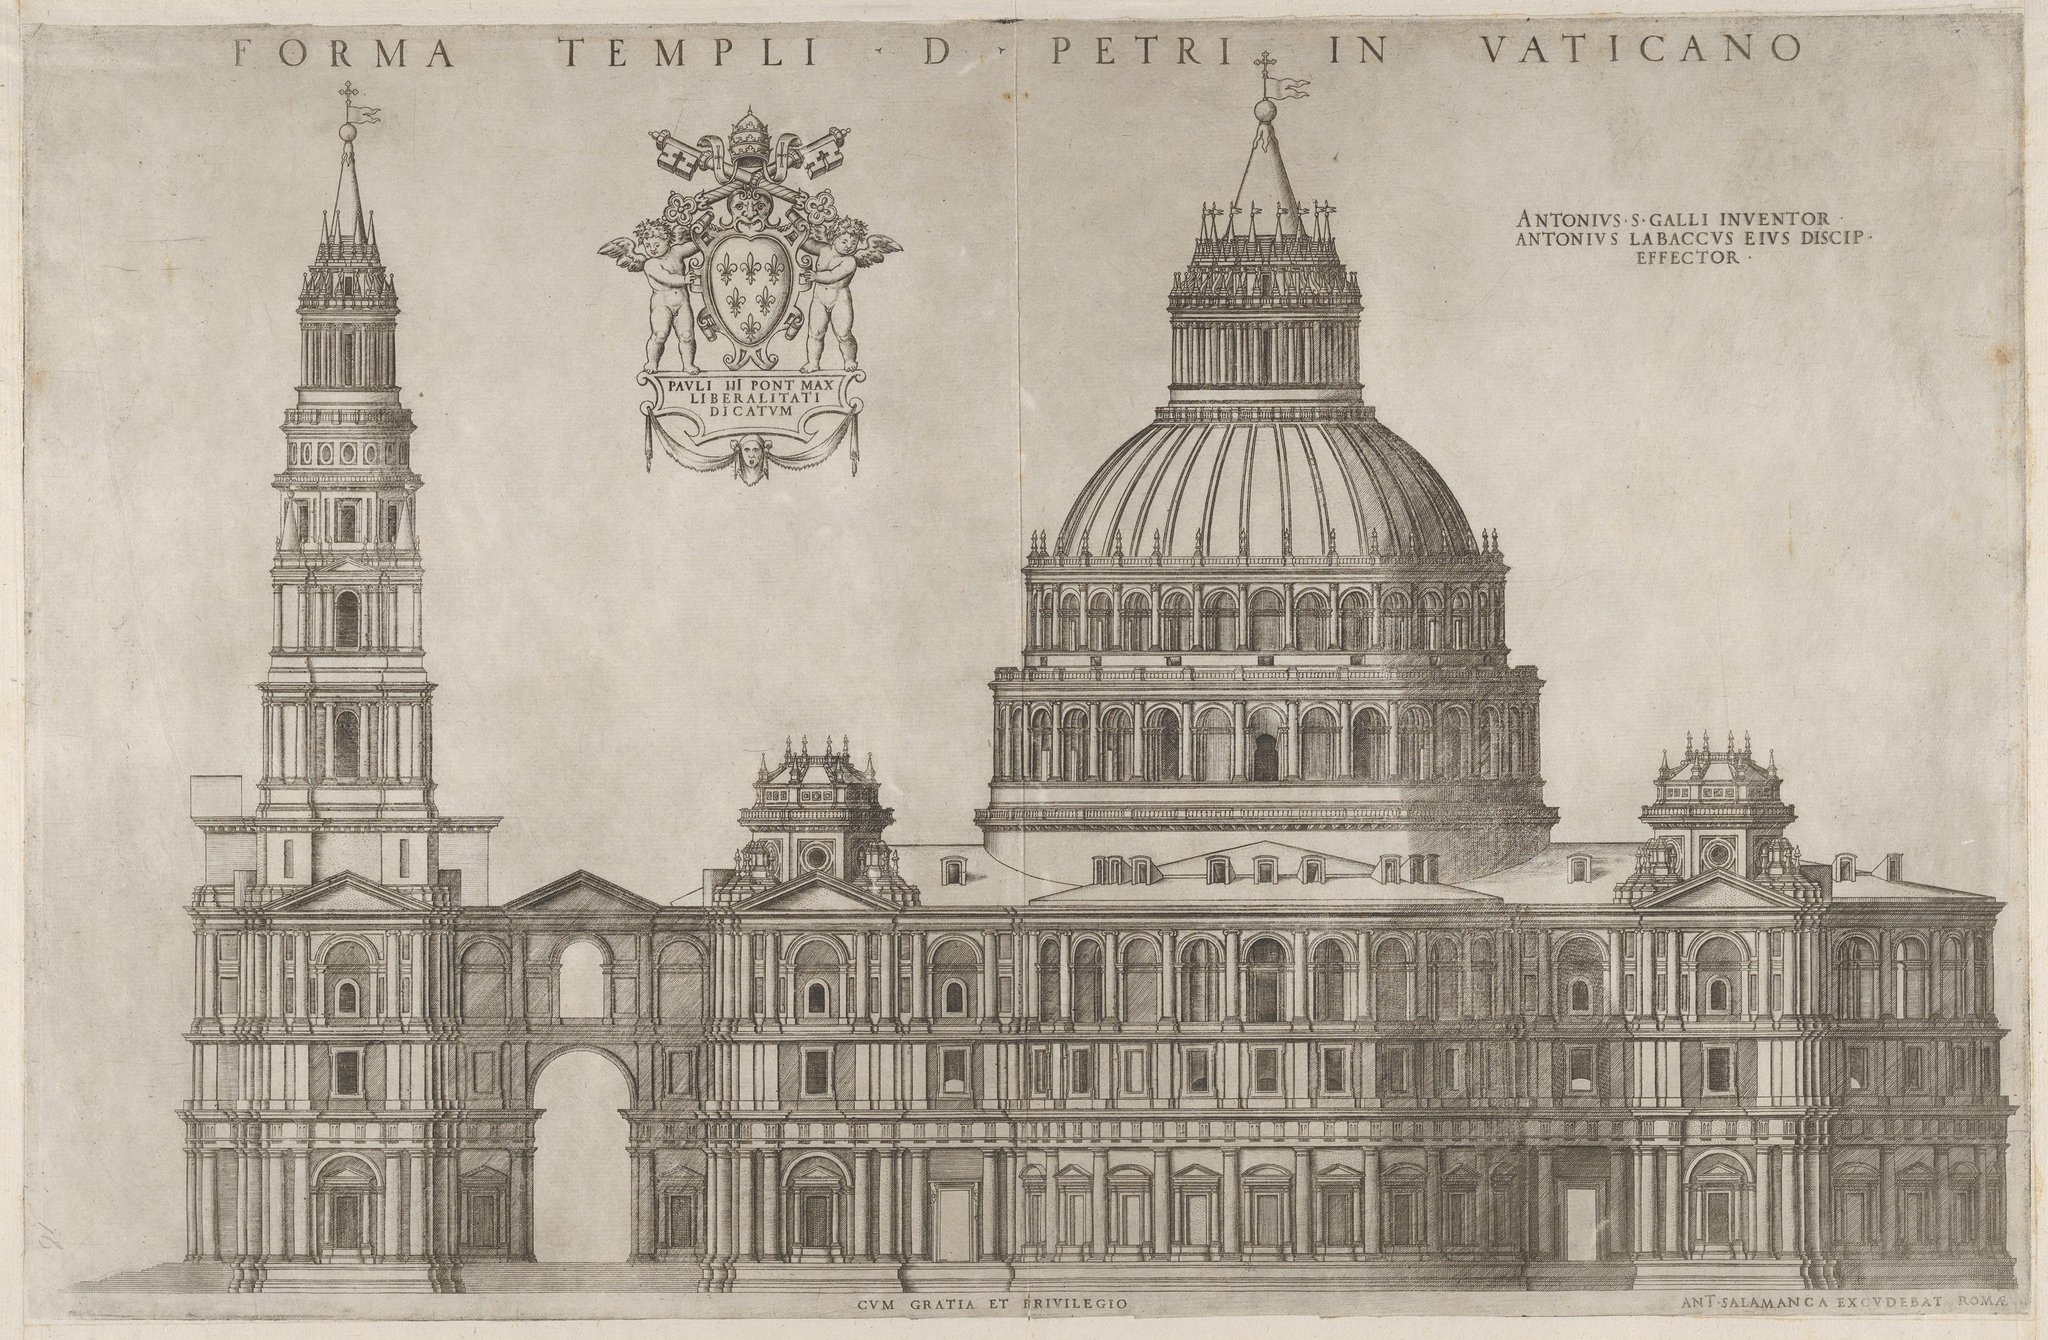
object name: print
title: Design for the Basilica of St. Peter's in the Vatican, from "Speculum Romanae Magnificentiae"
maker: antonio da labacco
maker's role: artist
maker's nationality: italian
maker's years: 1495-1567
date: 1501-1600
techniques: engraving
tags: churches,coat of arms,rome